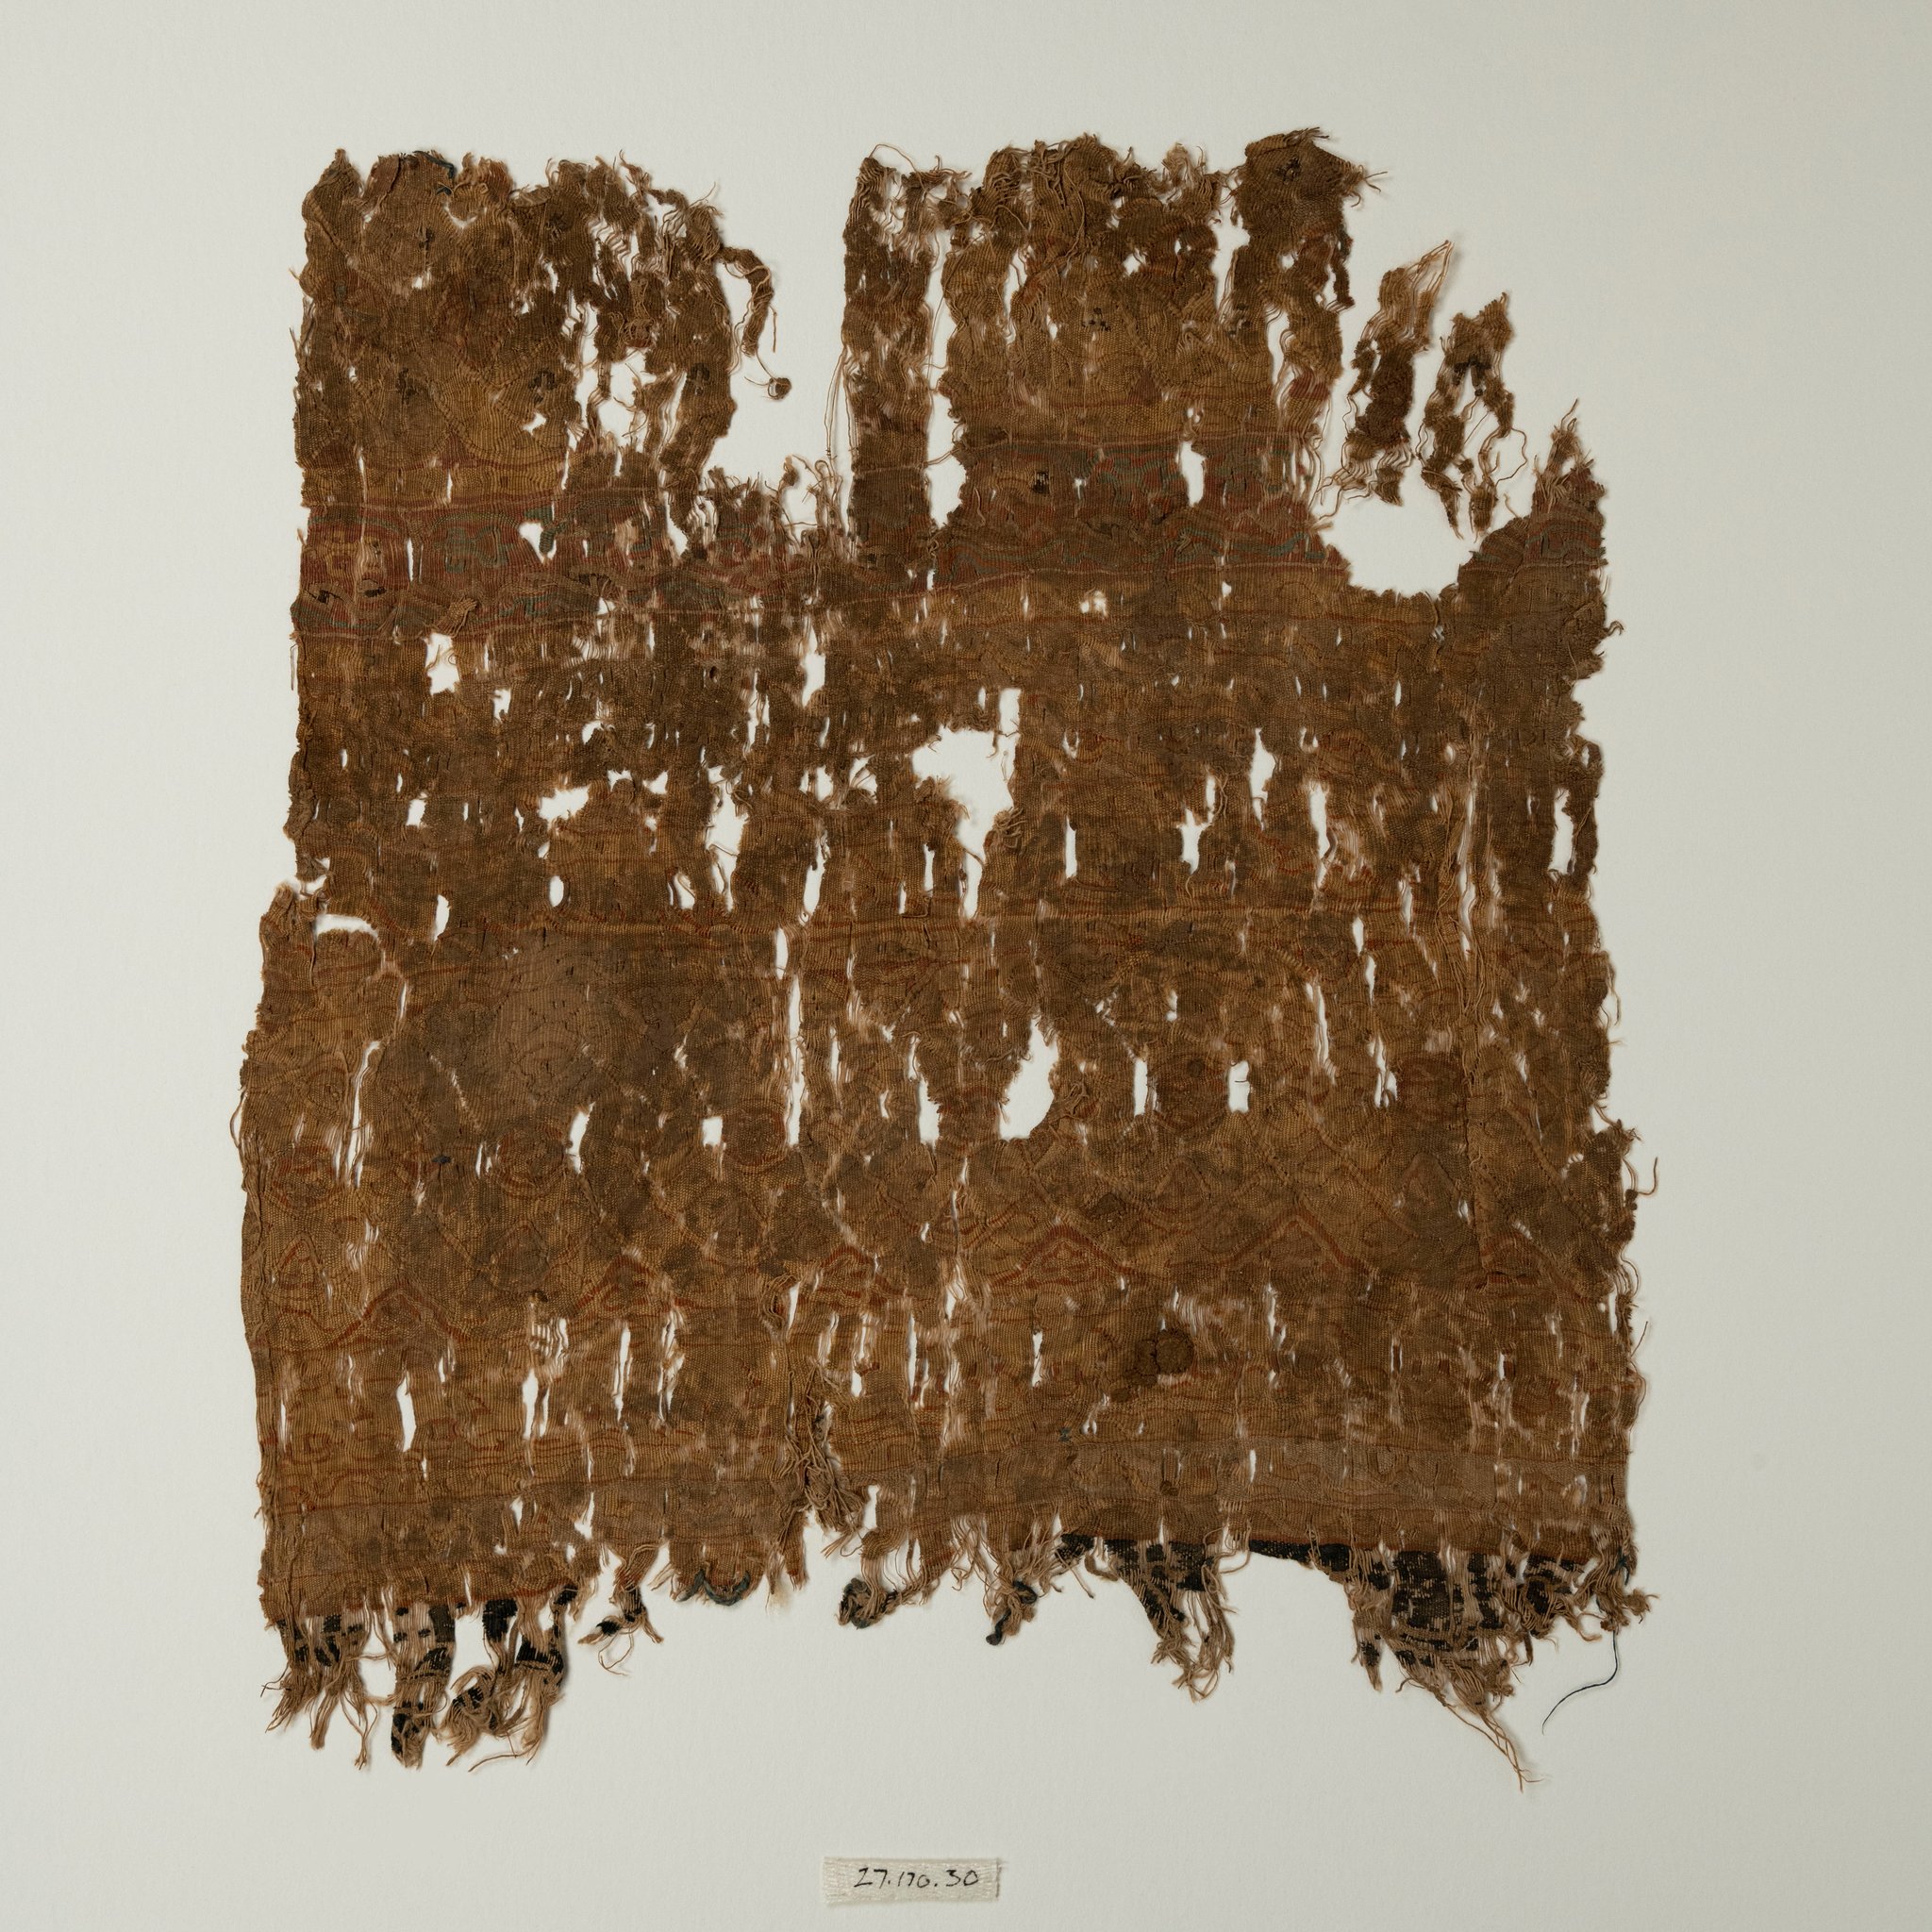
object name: textile fragment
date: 1101-1200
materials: linen, silk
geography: egypt